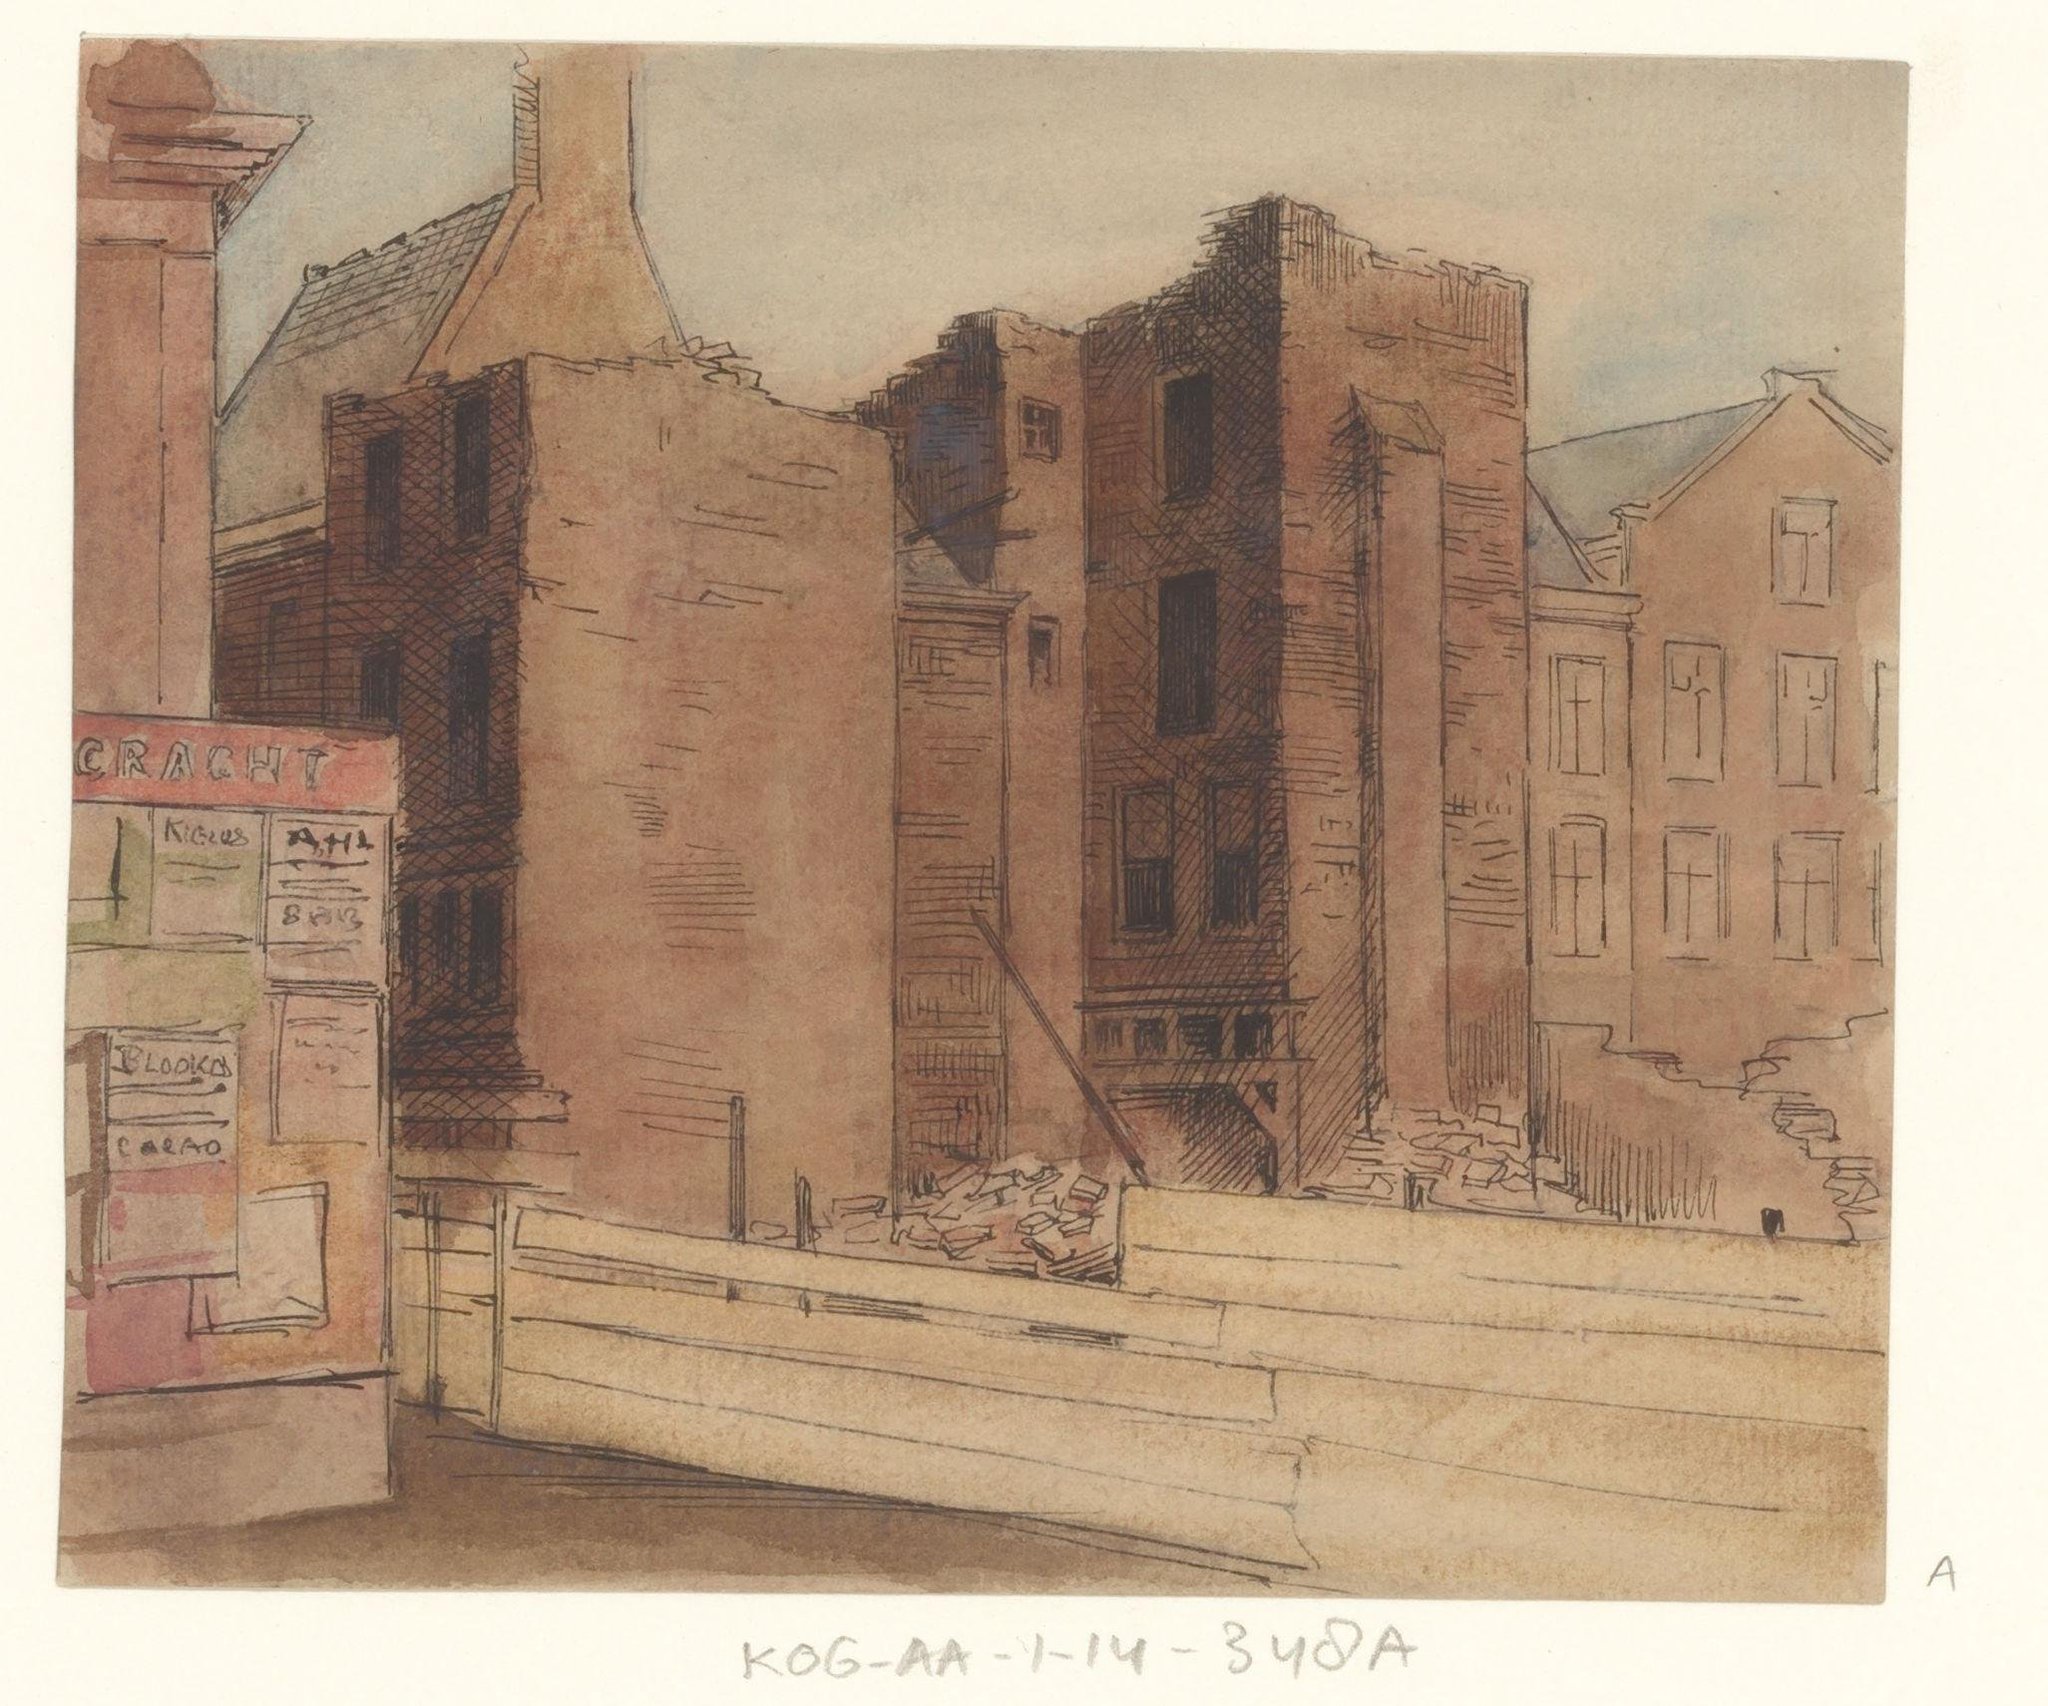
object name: drawing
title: Gezicht op de afbraak van huizen aan de Nieuwezijds Voorburgwal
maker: willem steelink (ii)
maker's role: draughtsman, print maker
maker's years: 1856-1928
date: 1866-1928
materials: ink, paper, pencil, watercolor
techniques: brush, pen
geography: amsterdam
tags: city-view in general; 'veduta', demolition of building, the usual house or row of houses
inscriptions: collector's mark: ‘14’ Lugt 1641b, inscription: ‘boven links’, inscription: ‘Port. 14 - 348a’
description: Onderwerpsrubriek binnen de Atlas Amsterdam: Verhulststraat (Johannes), Viaducten, Vierwindenstraat, Vinkenbuurt, Vinkenpad, Vinkenstraat, Vischsteeg, Vliegendesteeg, Voetboogstraat, Volewijk, Vondelstraat, Voorburgwal (N.Z.).